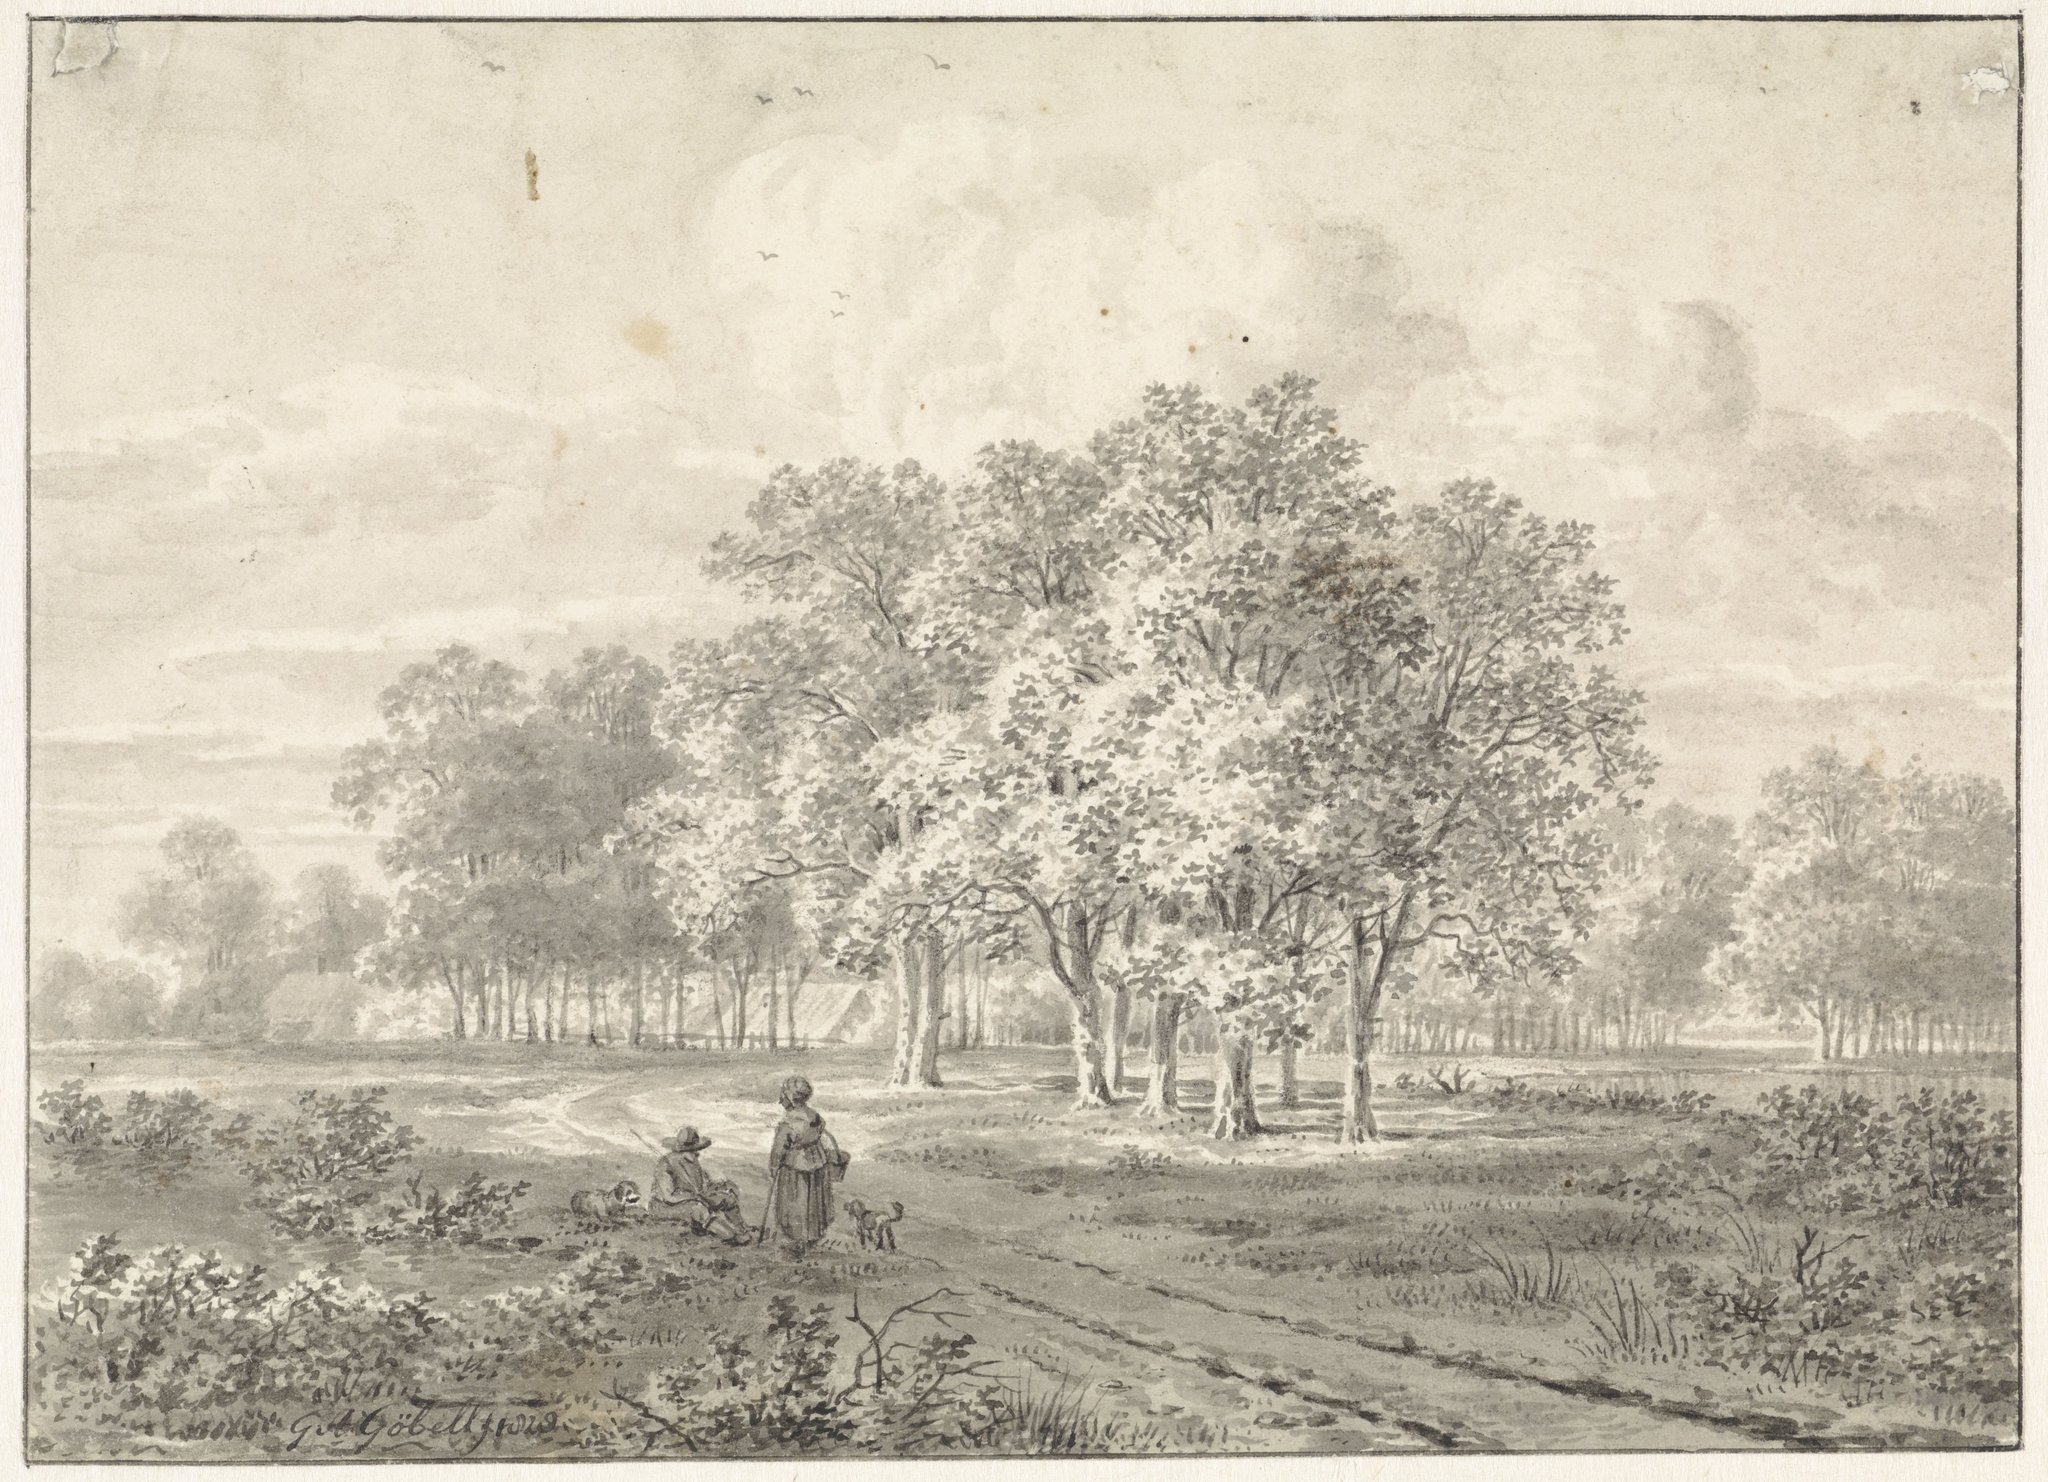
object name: drawing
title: Landschap bij Almelo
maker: gerrit hendrik gobell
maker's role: draughtsman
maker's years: 1786-1833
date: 1828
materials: chalk, paper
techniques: brush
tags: landscapes in the temperate zone